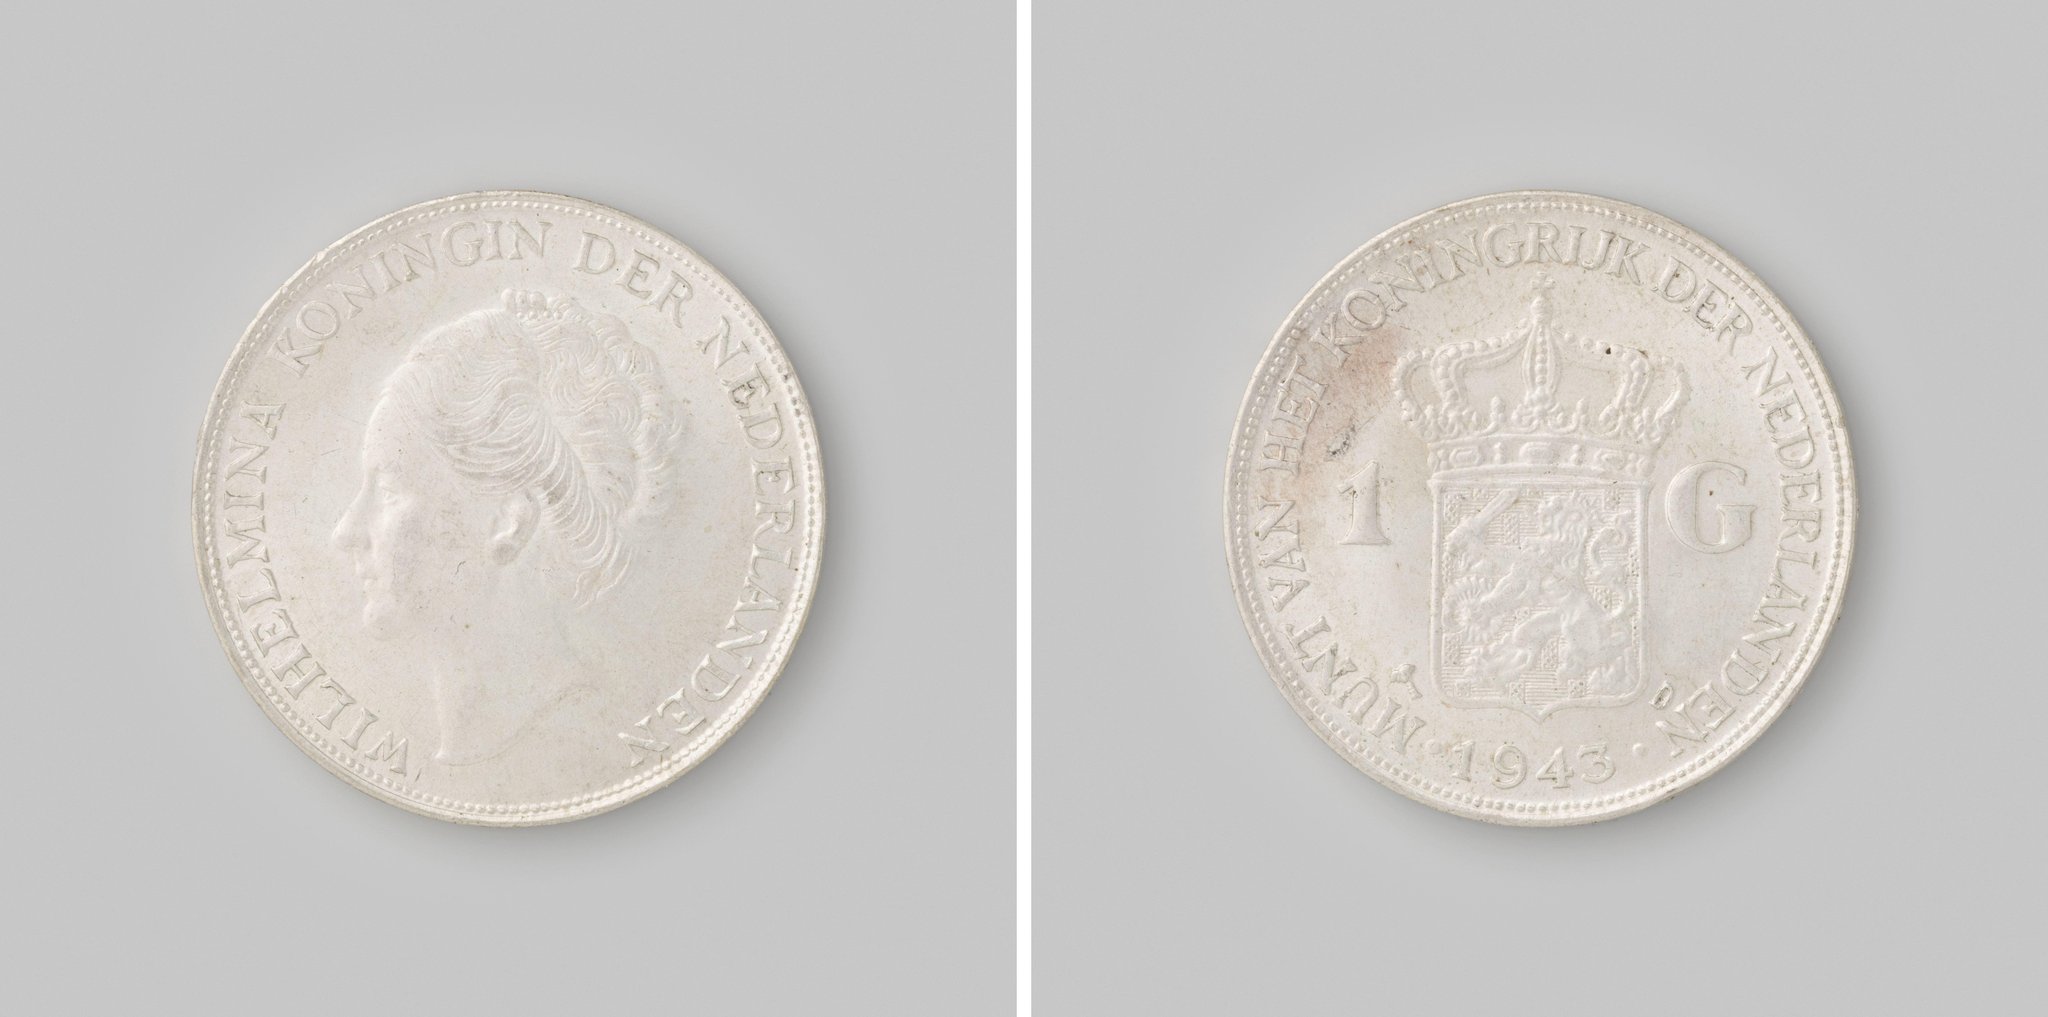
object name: coin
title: Nederlandse gulden voor Nederlands-Indië, 1943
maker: wilhelmina of the netherlands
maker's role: print maker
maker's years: 1880-1962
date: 1943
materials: silver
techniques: striking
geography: denver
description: Zilveren munt. Voorzijde: hoofd naar links. Keerzijde: tussen waarde-aanduiding 1 G gekroond rijkswapenschild. Linksonder wapenschild palmboom en rechtsonder letter D [=Denver]. Jaartal onderaan in omschrift. Randschrift.